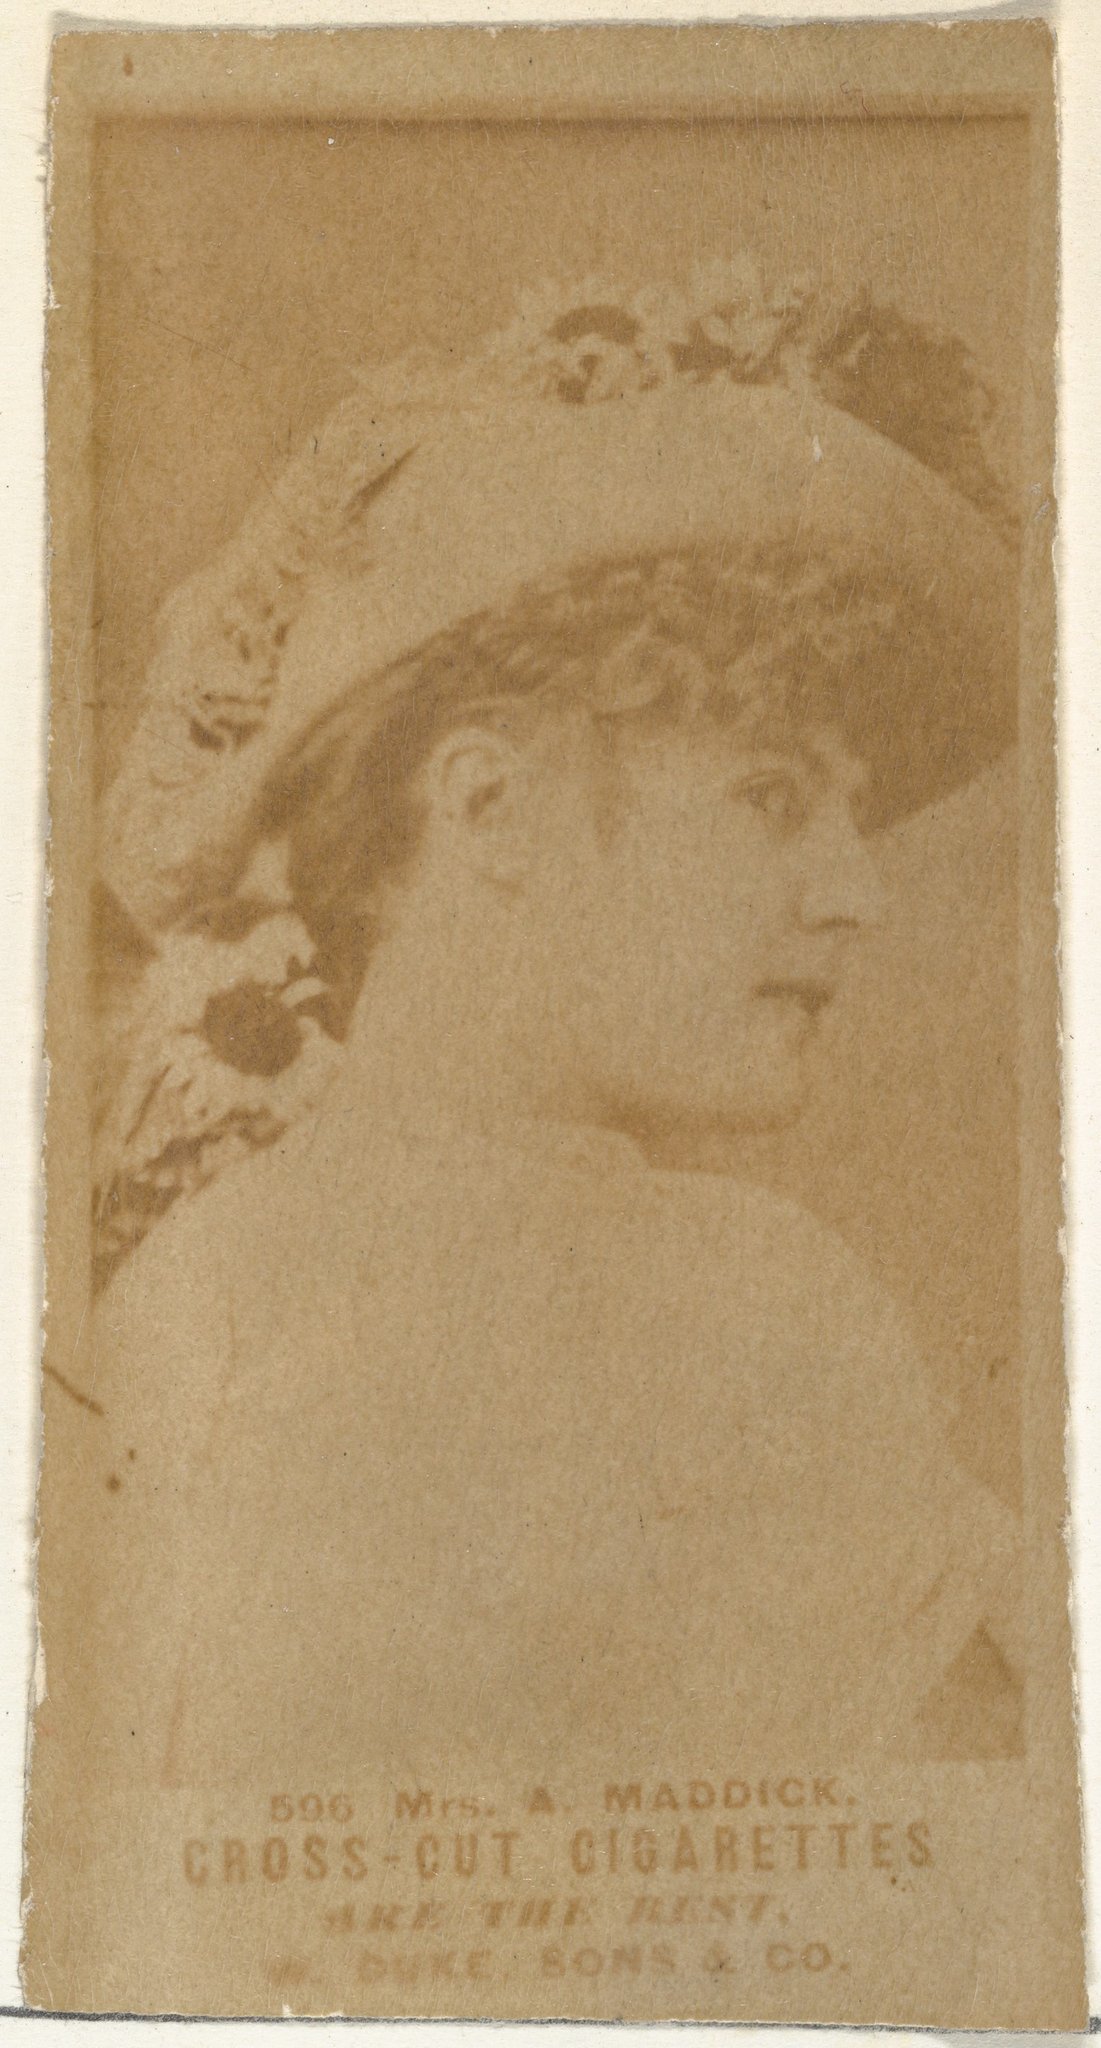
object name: photograph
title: Card Number 596, Mrs. A. Maddick, from the Actors and Actresses series (N145-3) issued by Duke Sons & Co. to promote Cross Cut Cigarettes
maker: w. duke, sons & co.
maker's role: publisher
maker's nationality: american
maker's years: 1870-1920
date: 1880-1889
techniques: albumen silver print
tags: women,actresses